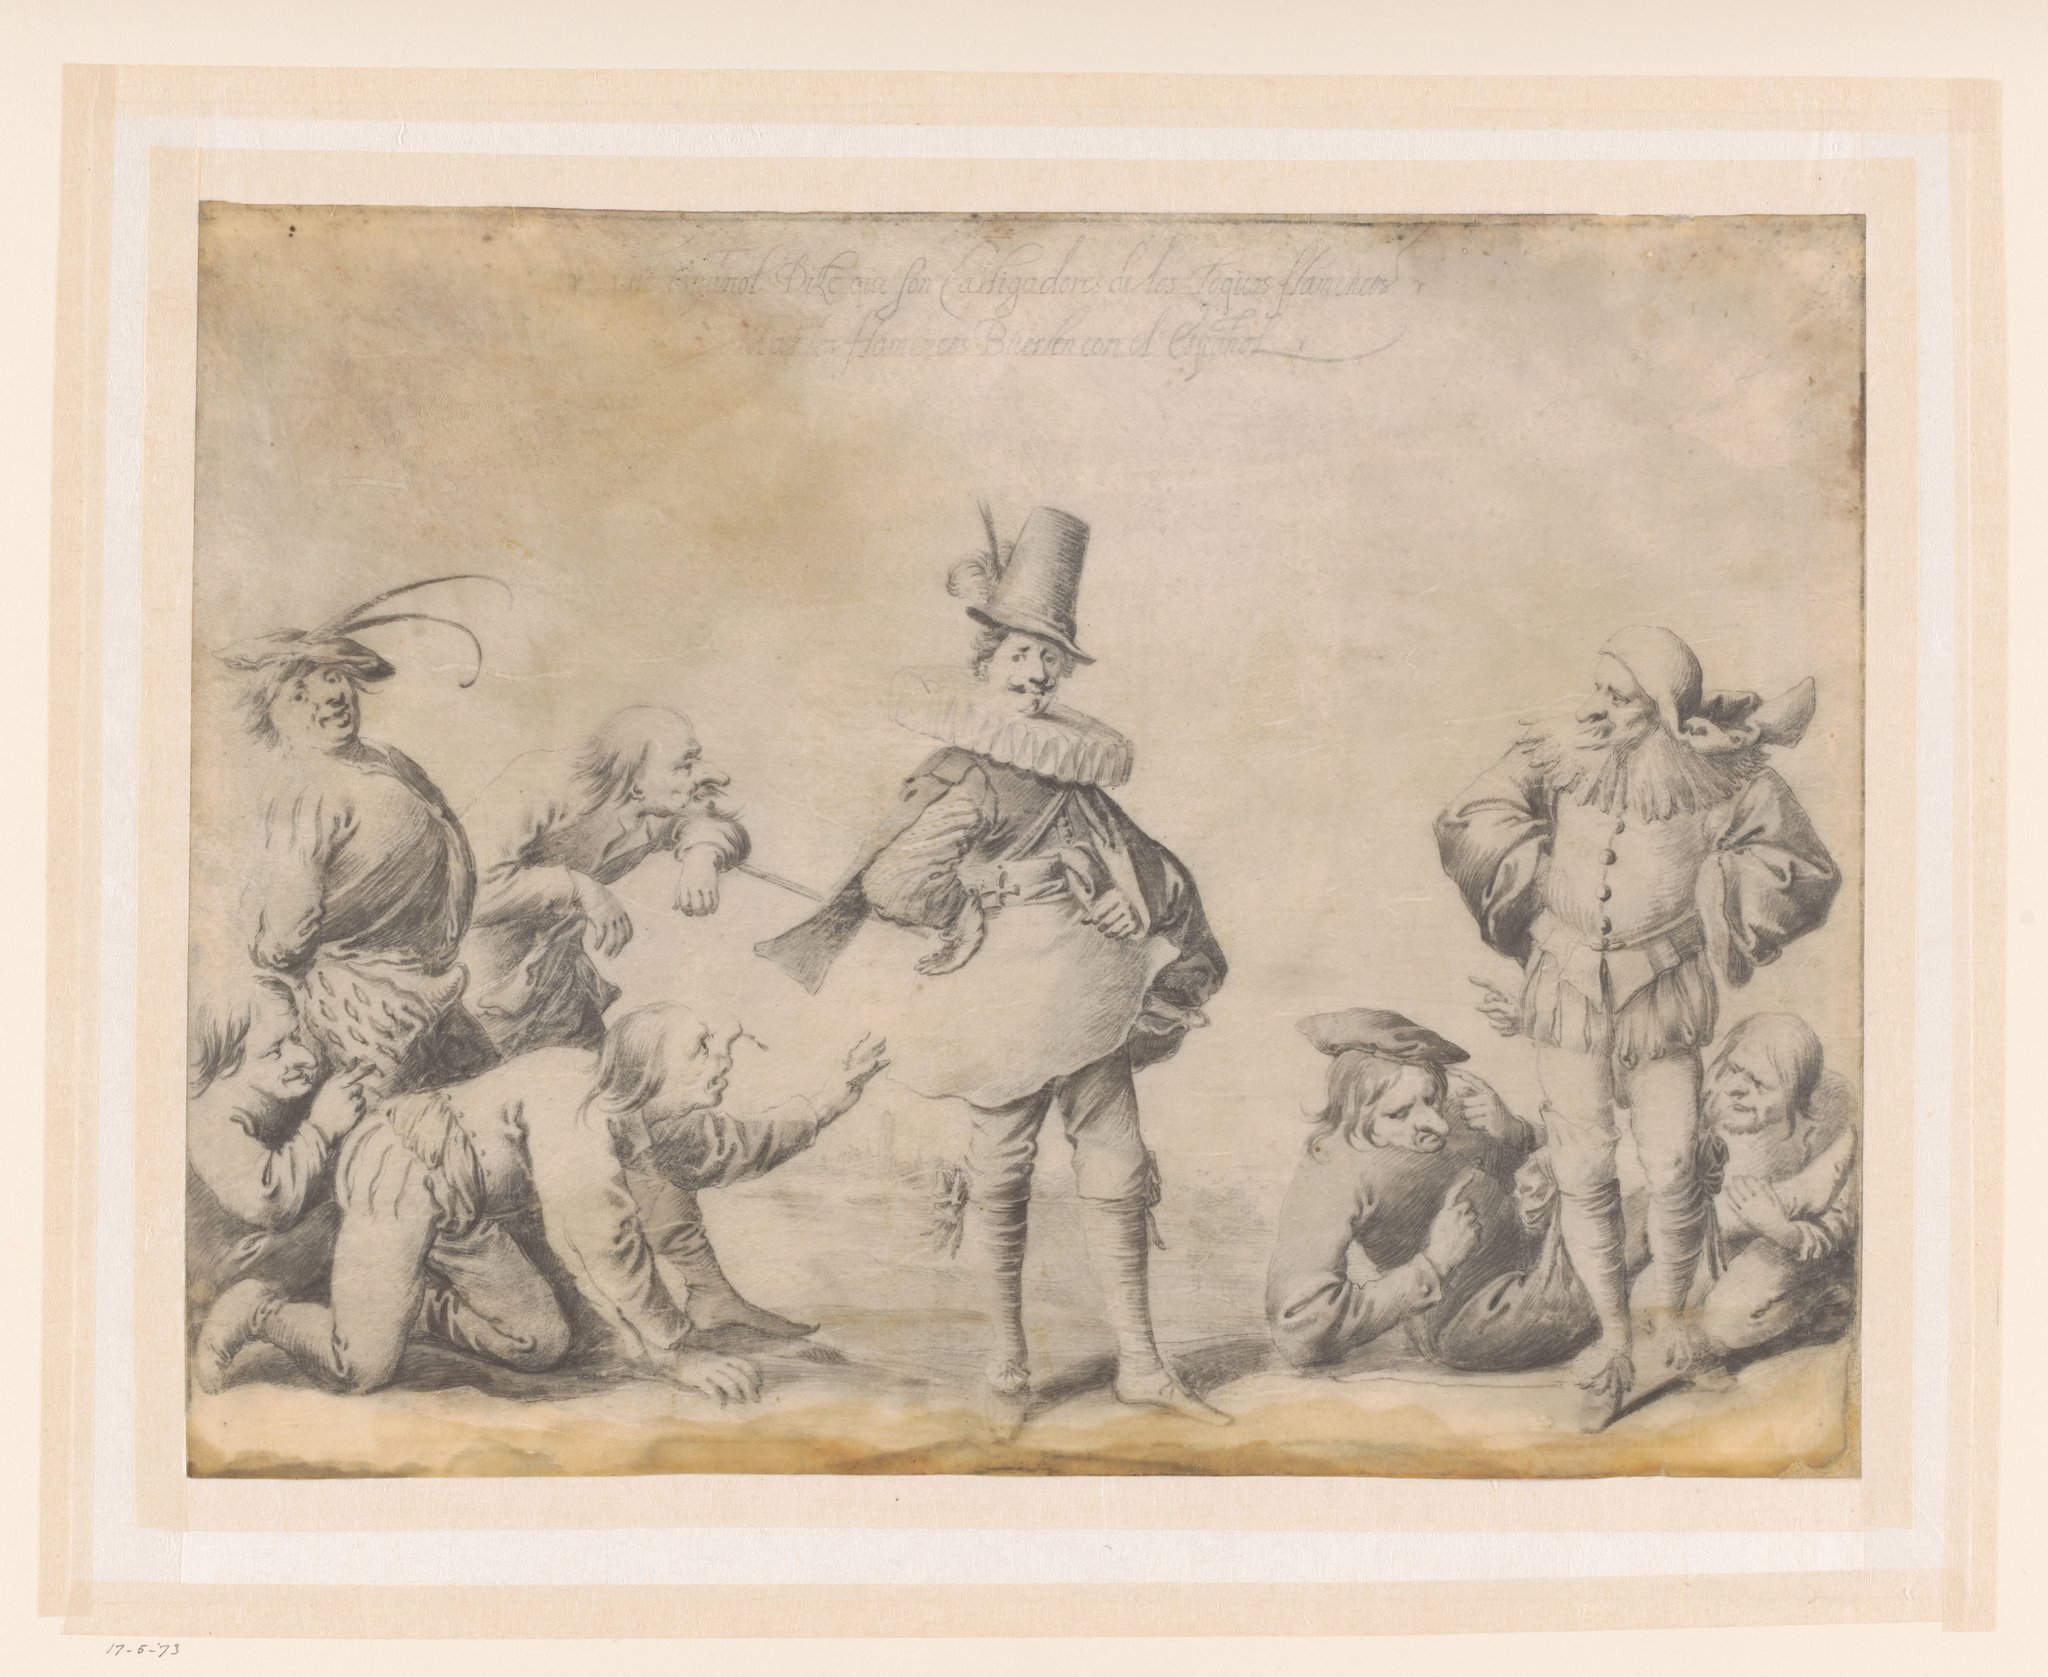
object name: drawing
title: Spotbeeld op de Spanjaard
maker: pieter jansz quast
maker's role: draughtsman, painter, print maker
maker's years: 1605-1647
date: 1644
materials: parchment, pencil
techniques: brush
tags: europeans: spaniards (+ caricatured)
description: Spottekening op de Spanjaard: een rijk uitgedoste Spanjaard staat te midden van zeven schooiers, die hem uitjouwen en bespotten.